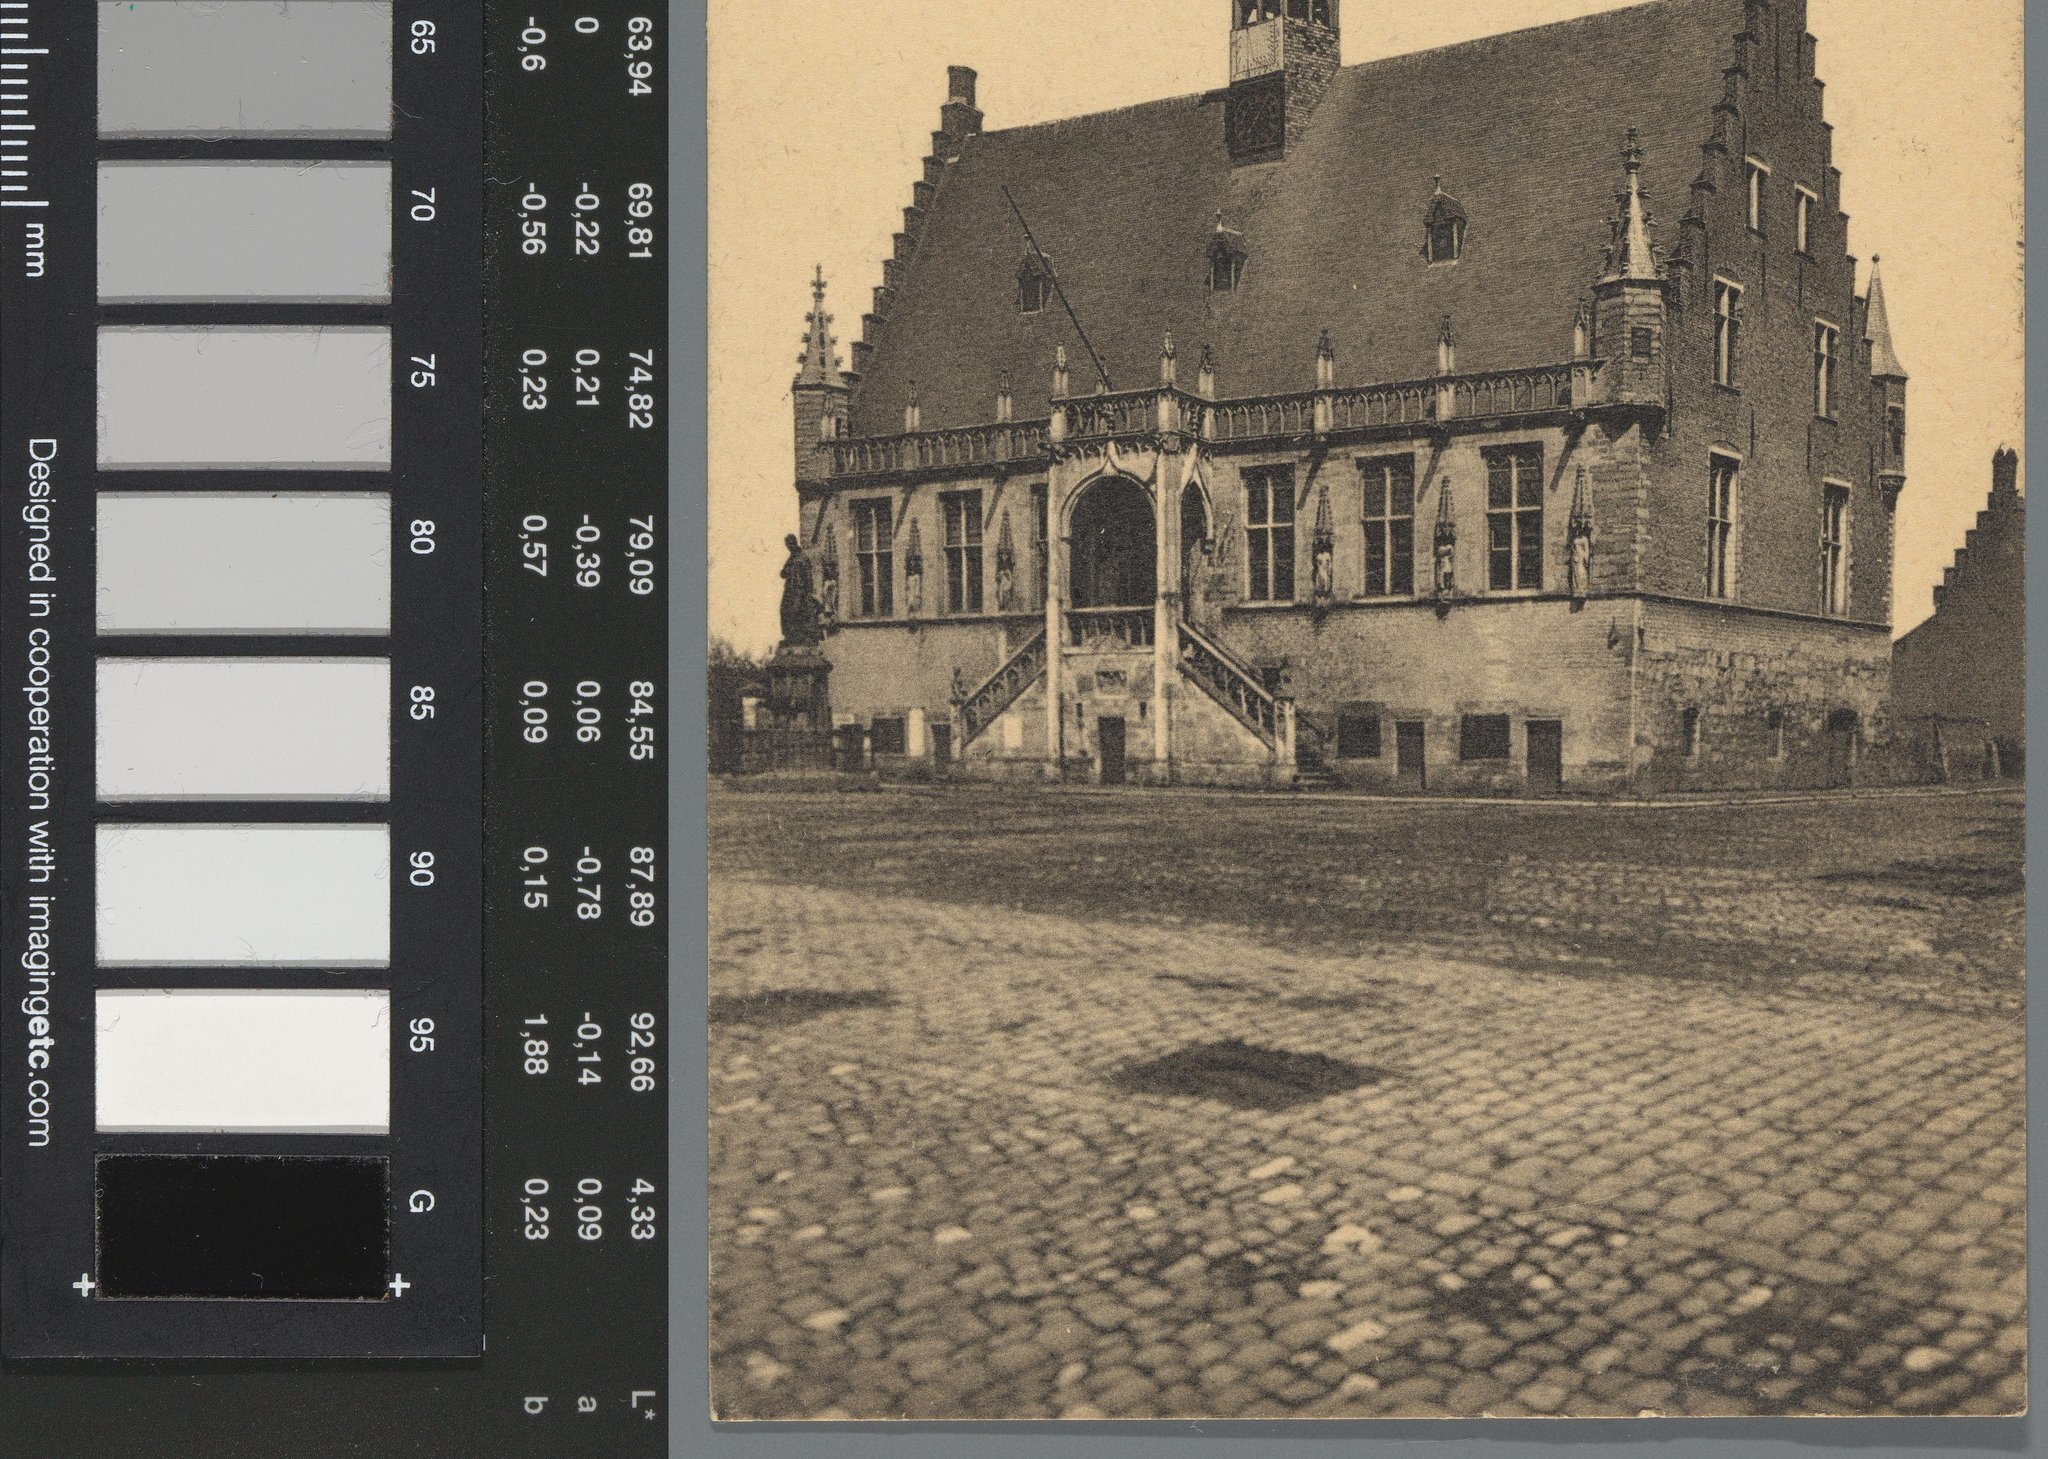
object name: postcard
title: Damme, Stadhuis. Hôtel de Ville (1464-68)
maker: wwe vintioen-sarazijn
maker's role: fotograaf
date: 1920-1950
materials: photographic support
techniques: photograph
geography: damme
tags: damme